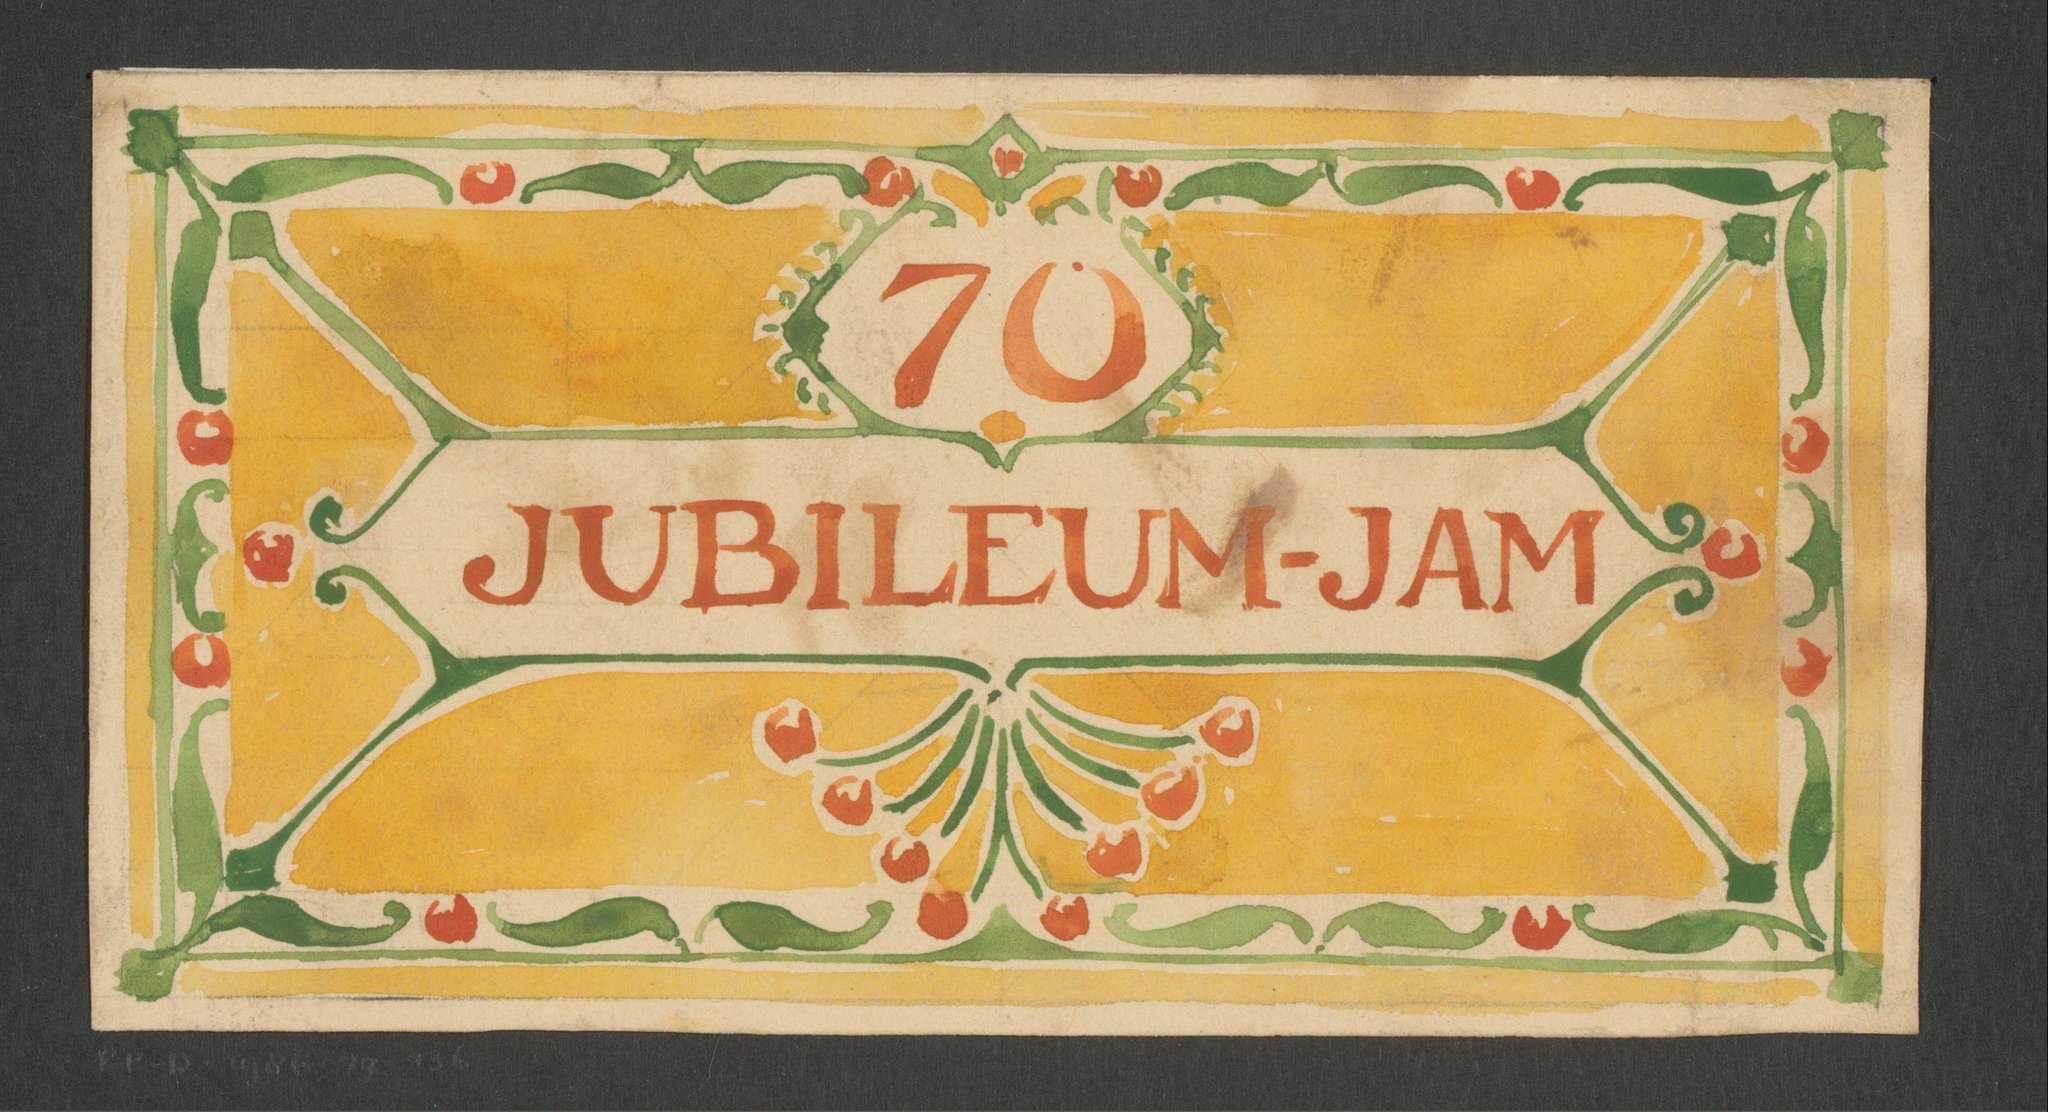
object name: drawing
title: Ontwerp voor een etiket voor jublileumjam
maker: reinier willem petrus de vries (1874-1953)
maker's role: draughtsman, print maker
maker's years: 1874-1953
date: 1884-1952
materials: paper, pencil, watercolor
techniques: brush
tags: fruits: cherry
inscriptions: collector's mark: ‘R:MVS.’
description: Ontwerp met een patroon van kersen en bladeren.